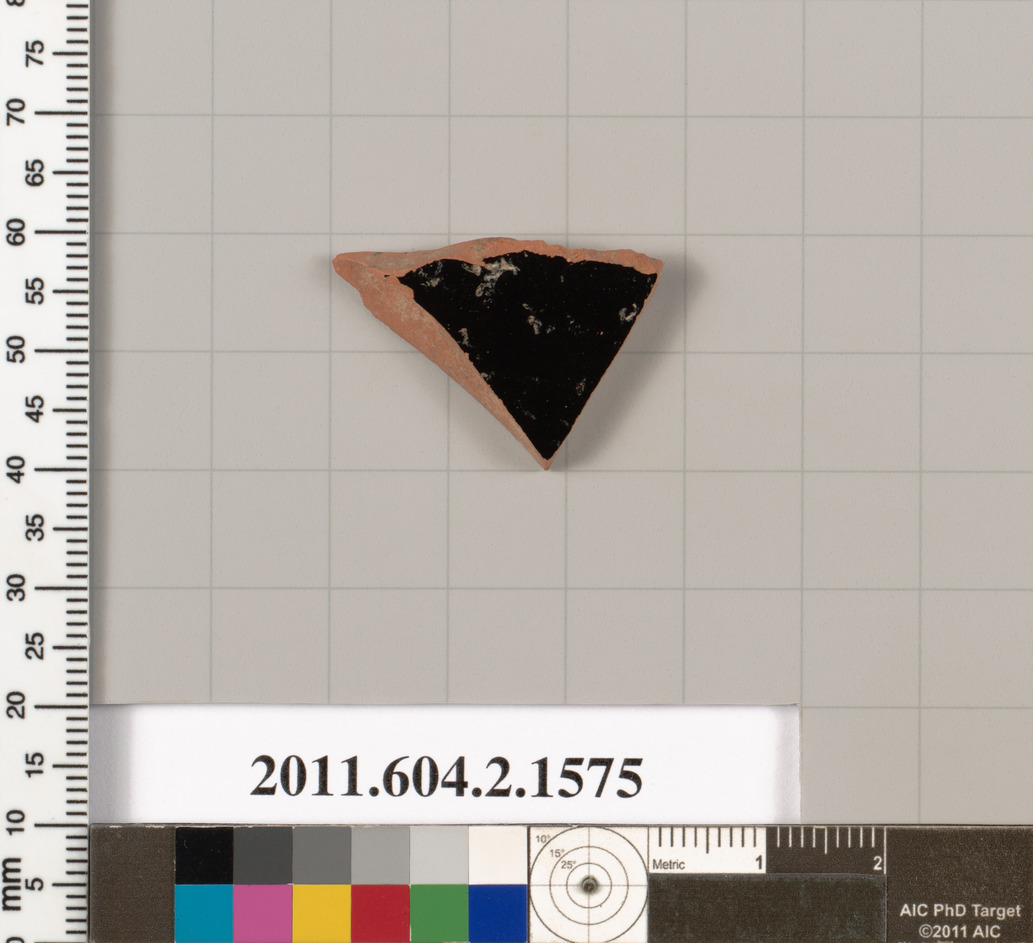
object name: skyphos fragment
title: Terracotta fragment of a skyphos (deep drinking cup)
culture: greek, attic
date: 600-401 BCE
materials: terracotta